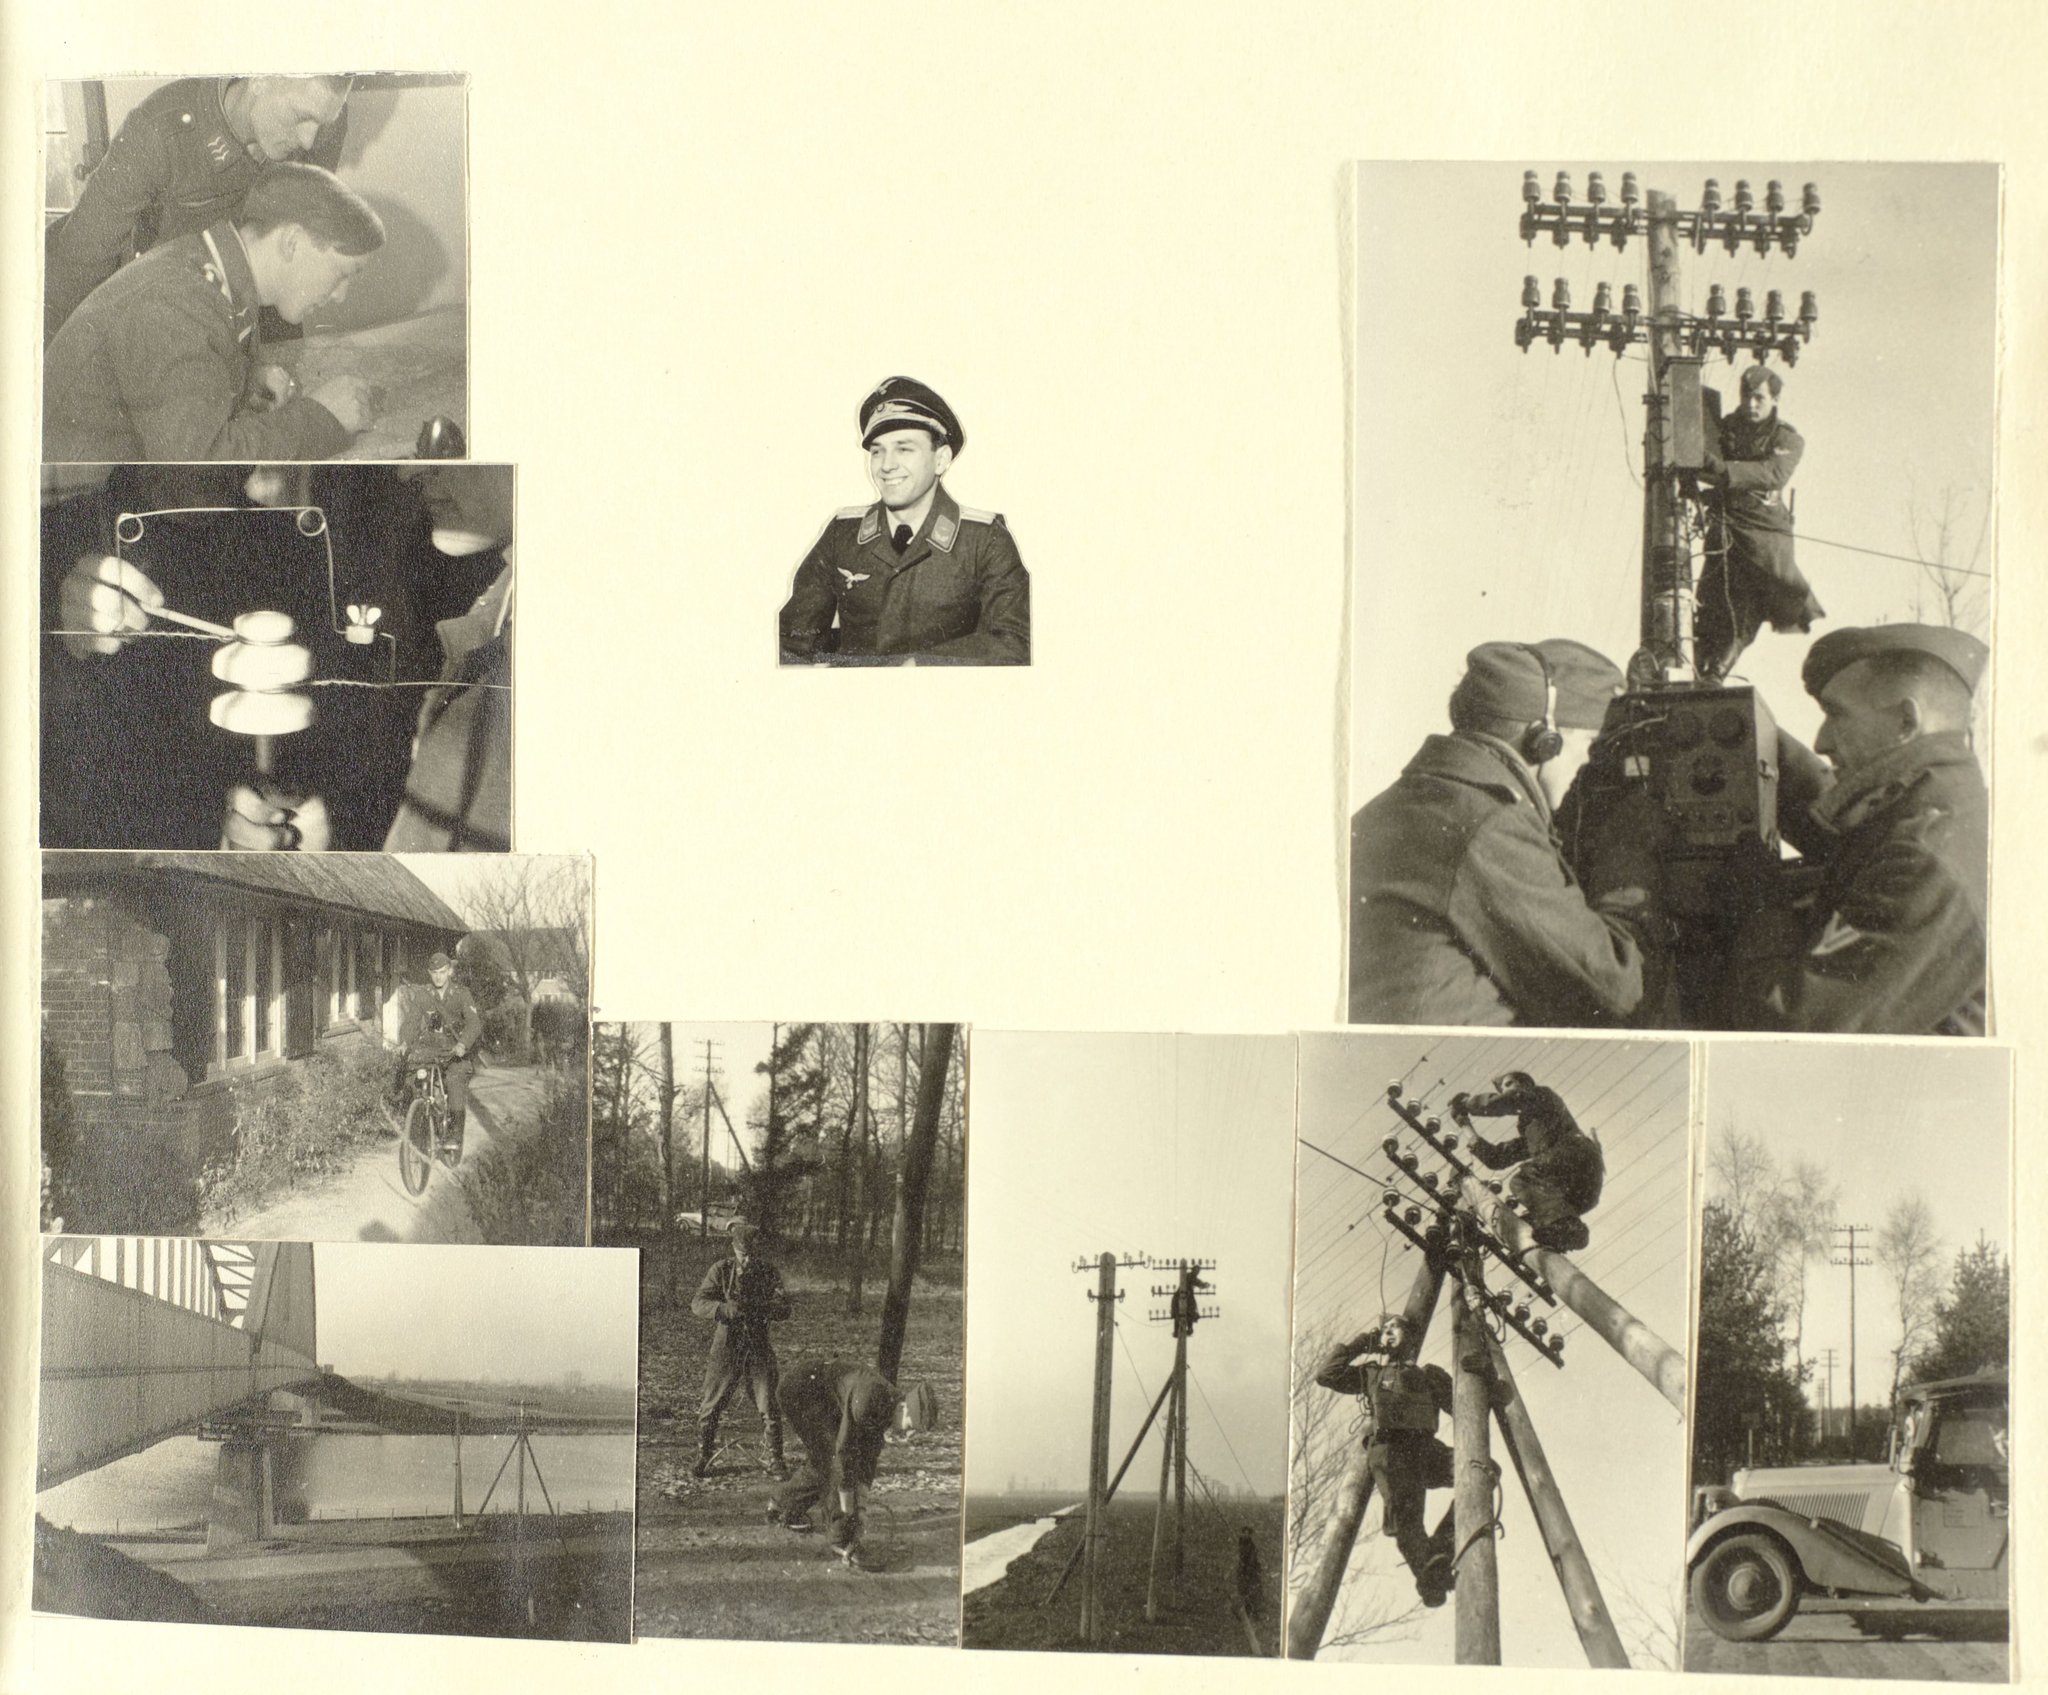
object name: photograph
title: Kabels trekken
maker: Anonymous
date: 1942-1943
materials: cardboard, photographic support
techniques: gelatin silver print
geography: eifel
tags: communication (military), netherlands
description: Albumblad met acht foto's van een technische afdeling die nieuwe telefoonleidingen aanleggen in de Eifel. Onderdeel van het fotoalbum van de Luftnachrichten-Regiment 211,1942-1943.